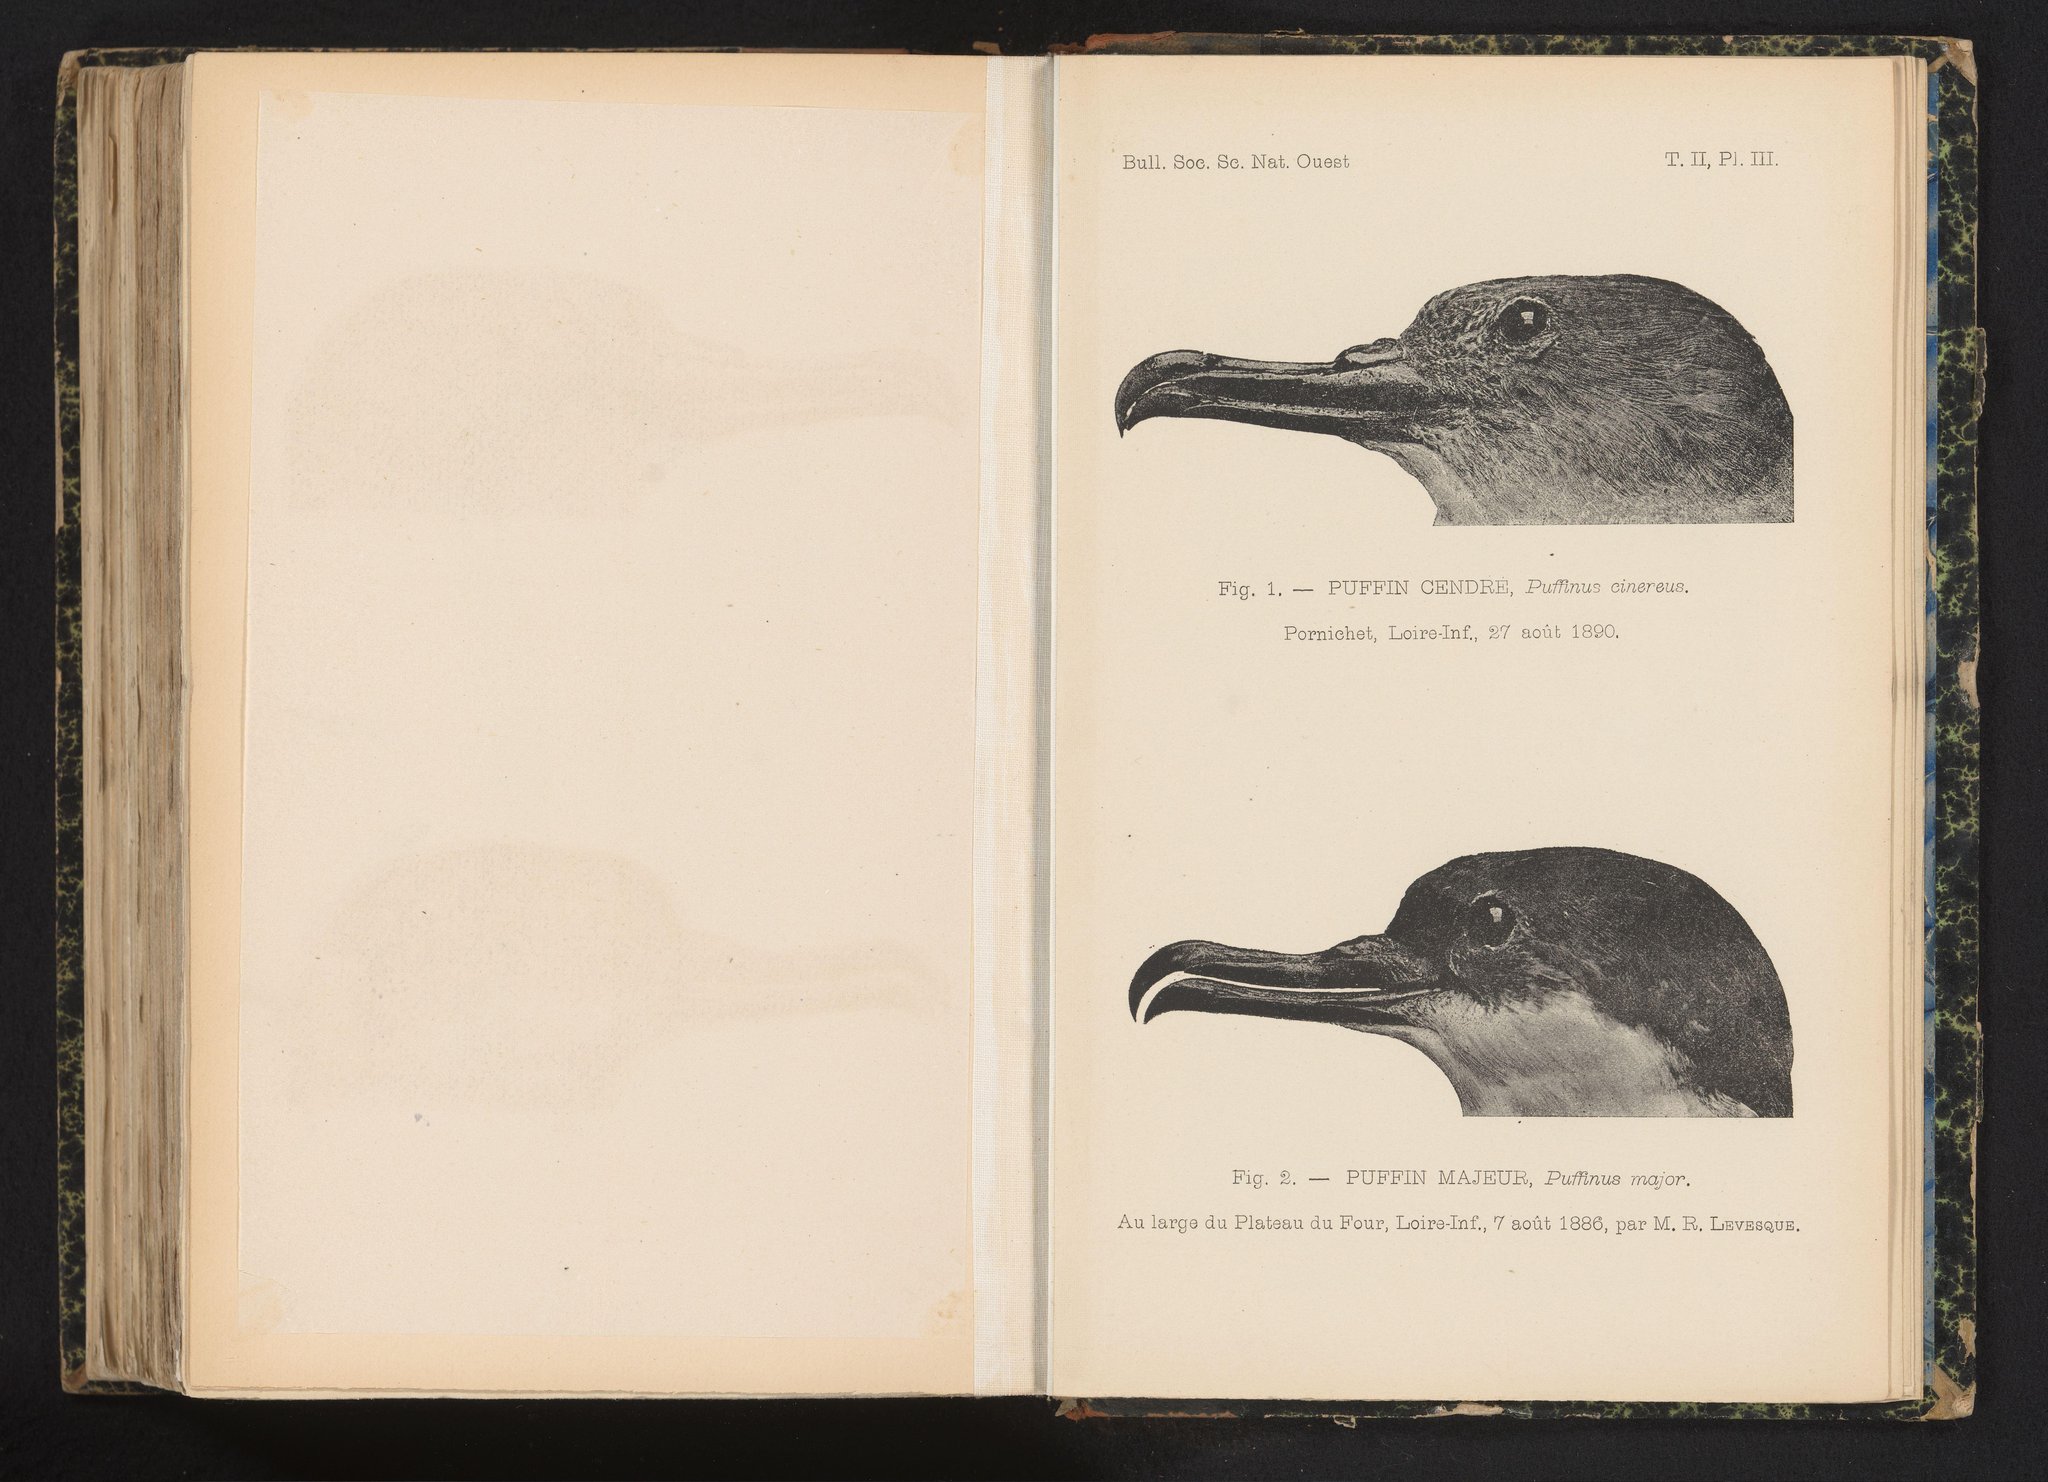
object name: page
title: Twee koppen van vogels behorend tot de Puffinus familie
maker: Anonymous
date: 1886-1891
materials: paper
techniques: autotype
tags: water-birds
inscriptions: inscription: ‘Fig. 1.- PUFFIN CENDRE, Puffinus cinereus./ Porchinet, Loire-Inf., 27 août 1890.’, inscription: ‘Fig. 2. - PUFFIN MAJEUR, Puffinus Major./ Au large du Plateau du Fourm Loire-Inf., 7 août 1886, par M. R. Levesque.’, number: ‘T. II, Pl. III.’